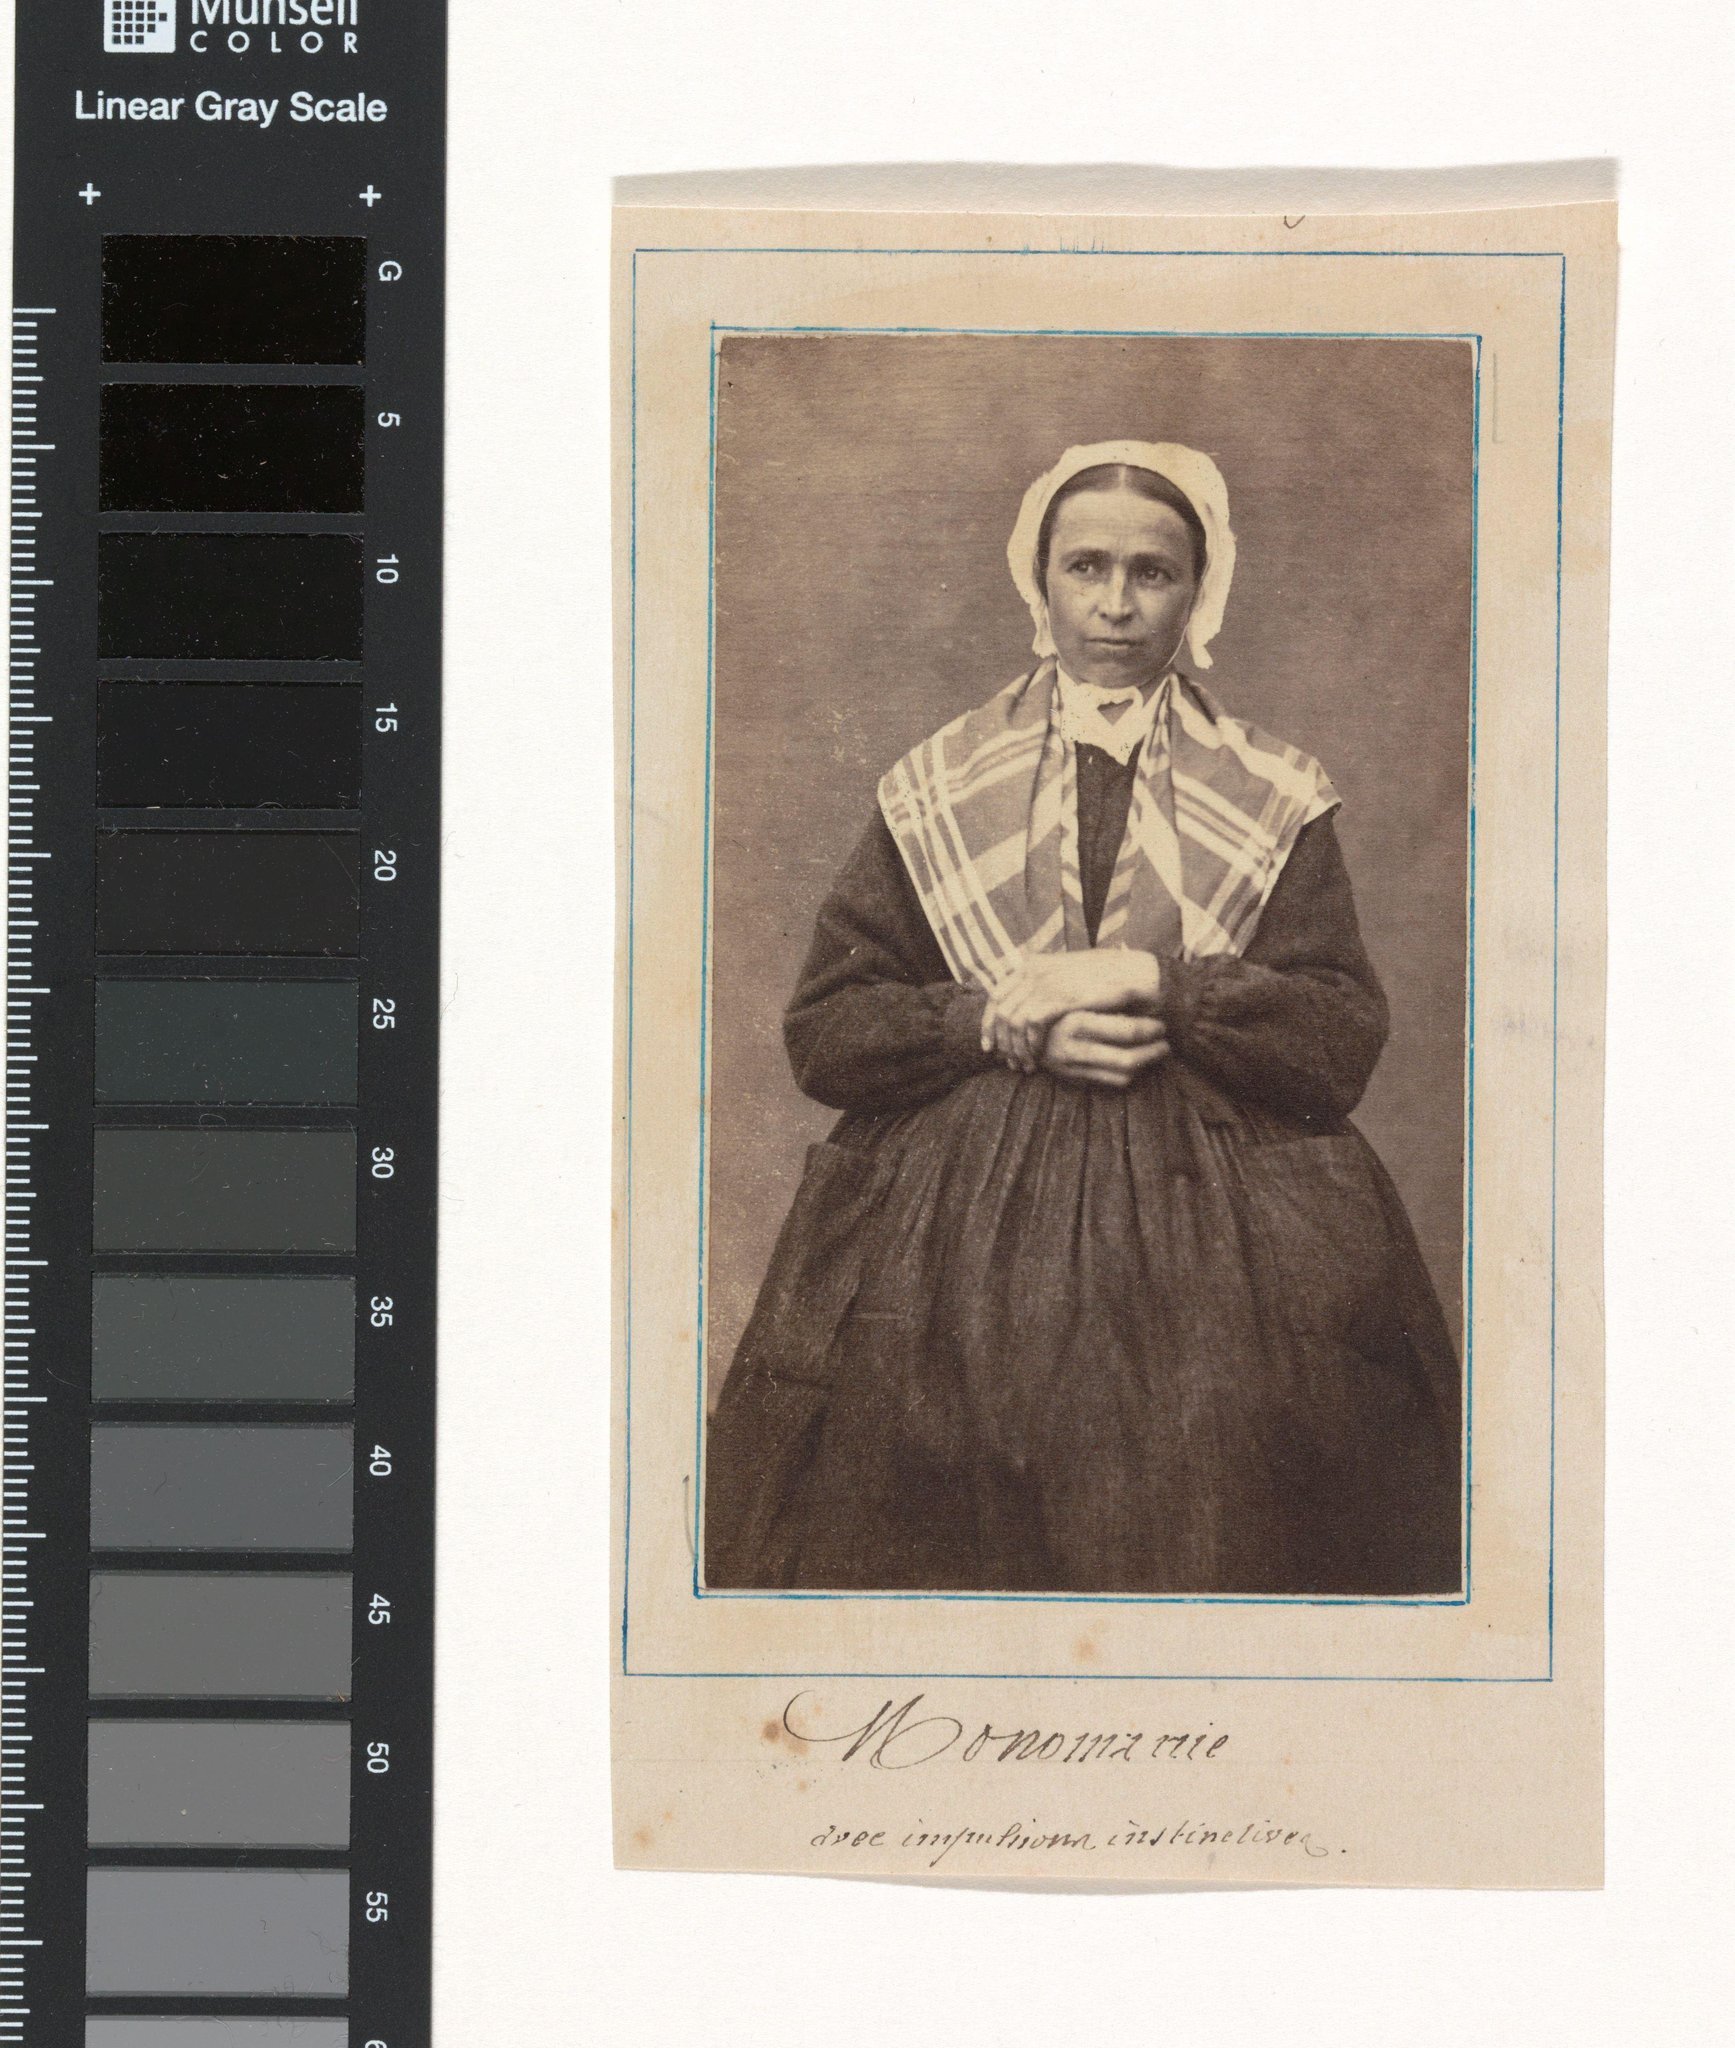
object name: photograph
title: Portret van een patiënt van een krankzinnigeninstelling, mogelijk Salpêtrière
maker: Anonymous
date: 1860-1885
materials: photographic support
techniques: albumen print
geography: france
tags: emotional illness, derangement, madness, historical persons not known by name - bb - woman, lunatic asylum, mental home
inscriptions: annotation: ‘monomanie’